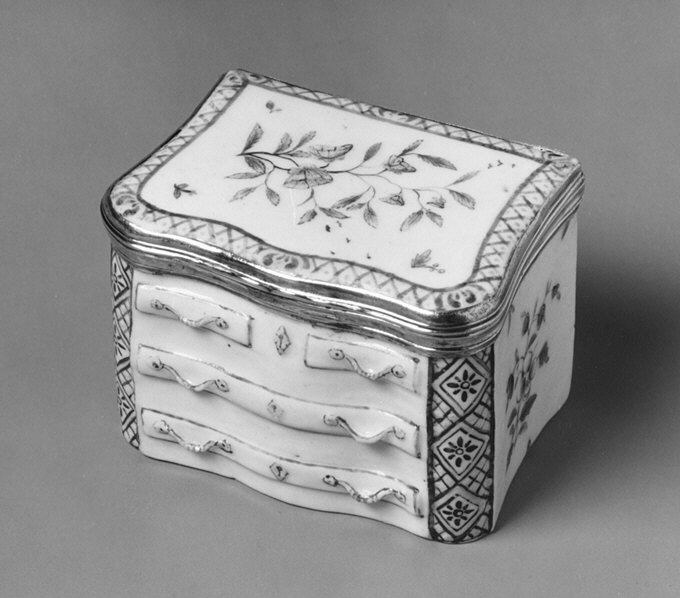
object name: snuffbox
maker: mennecy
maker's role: factory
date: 1751-1752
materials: silver, soft paste porcelain